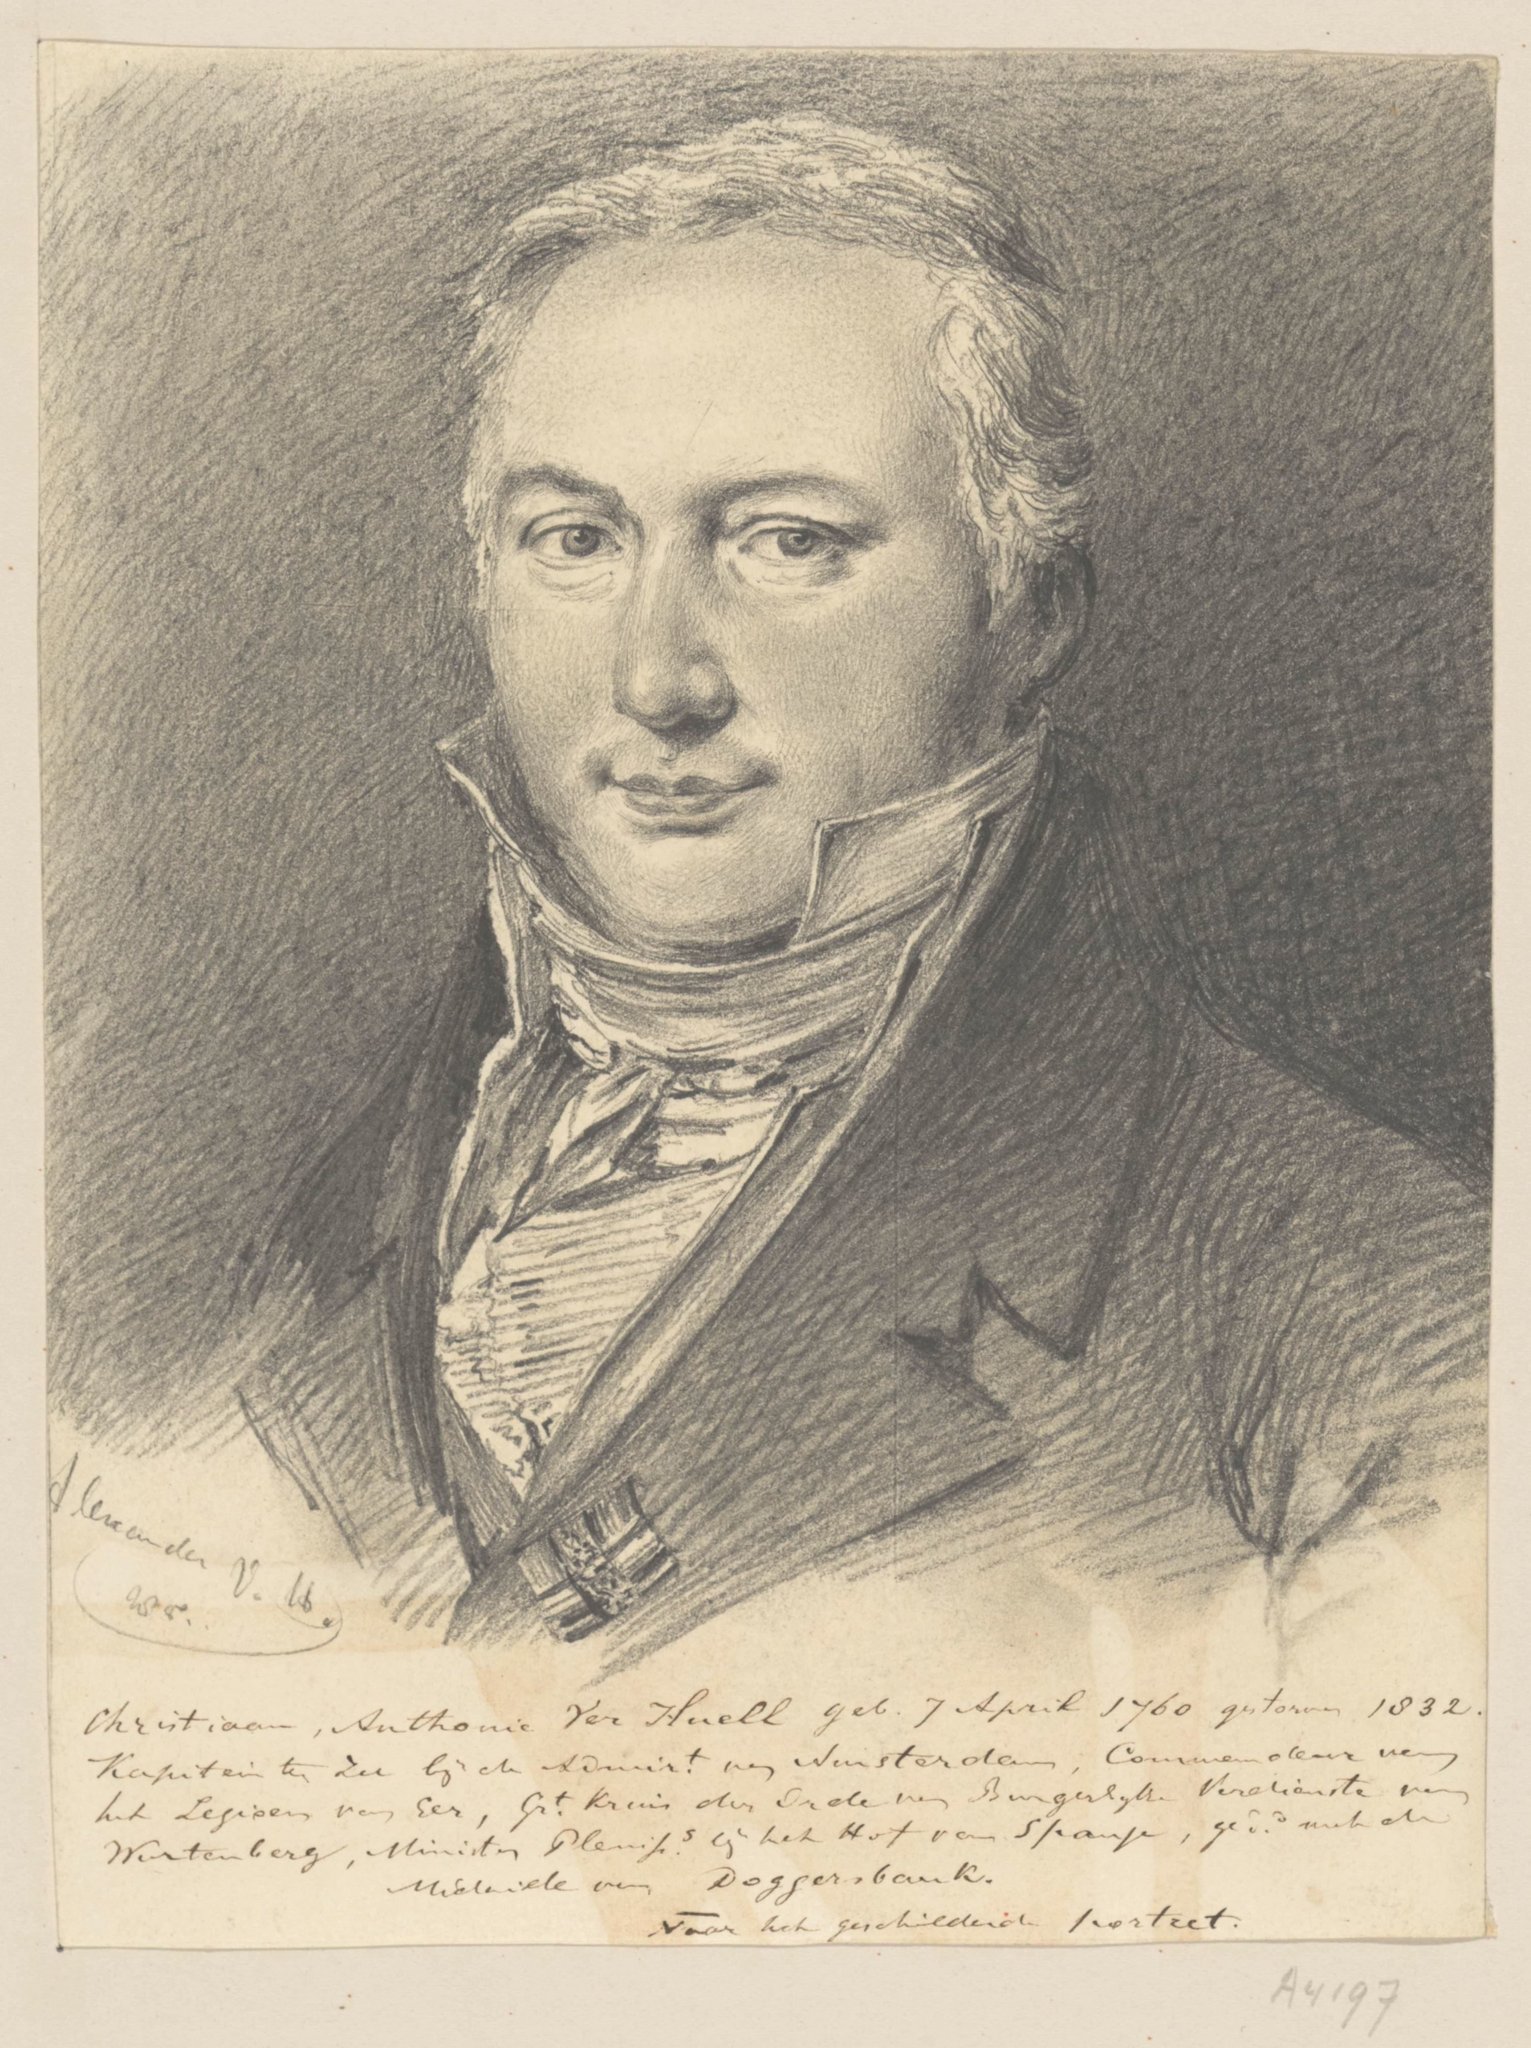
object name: drawing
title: Portret van Christiaan Anthonie Ver Huell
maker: alexander ver huell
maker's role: draughtsman, print maker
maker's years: 1822-1897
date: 1850-1859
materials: paper, pencil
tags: historical persons